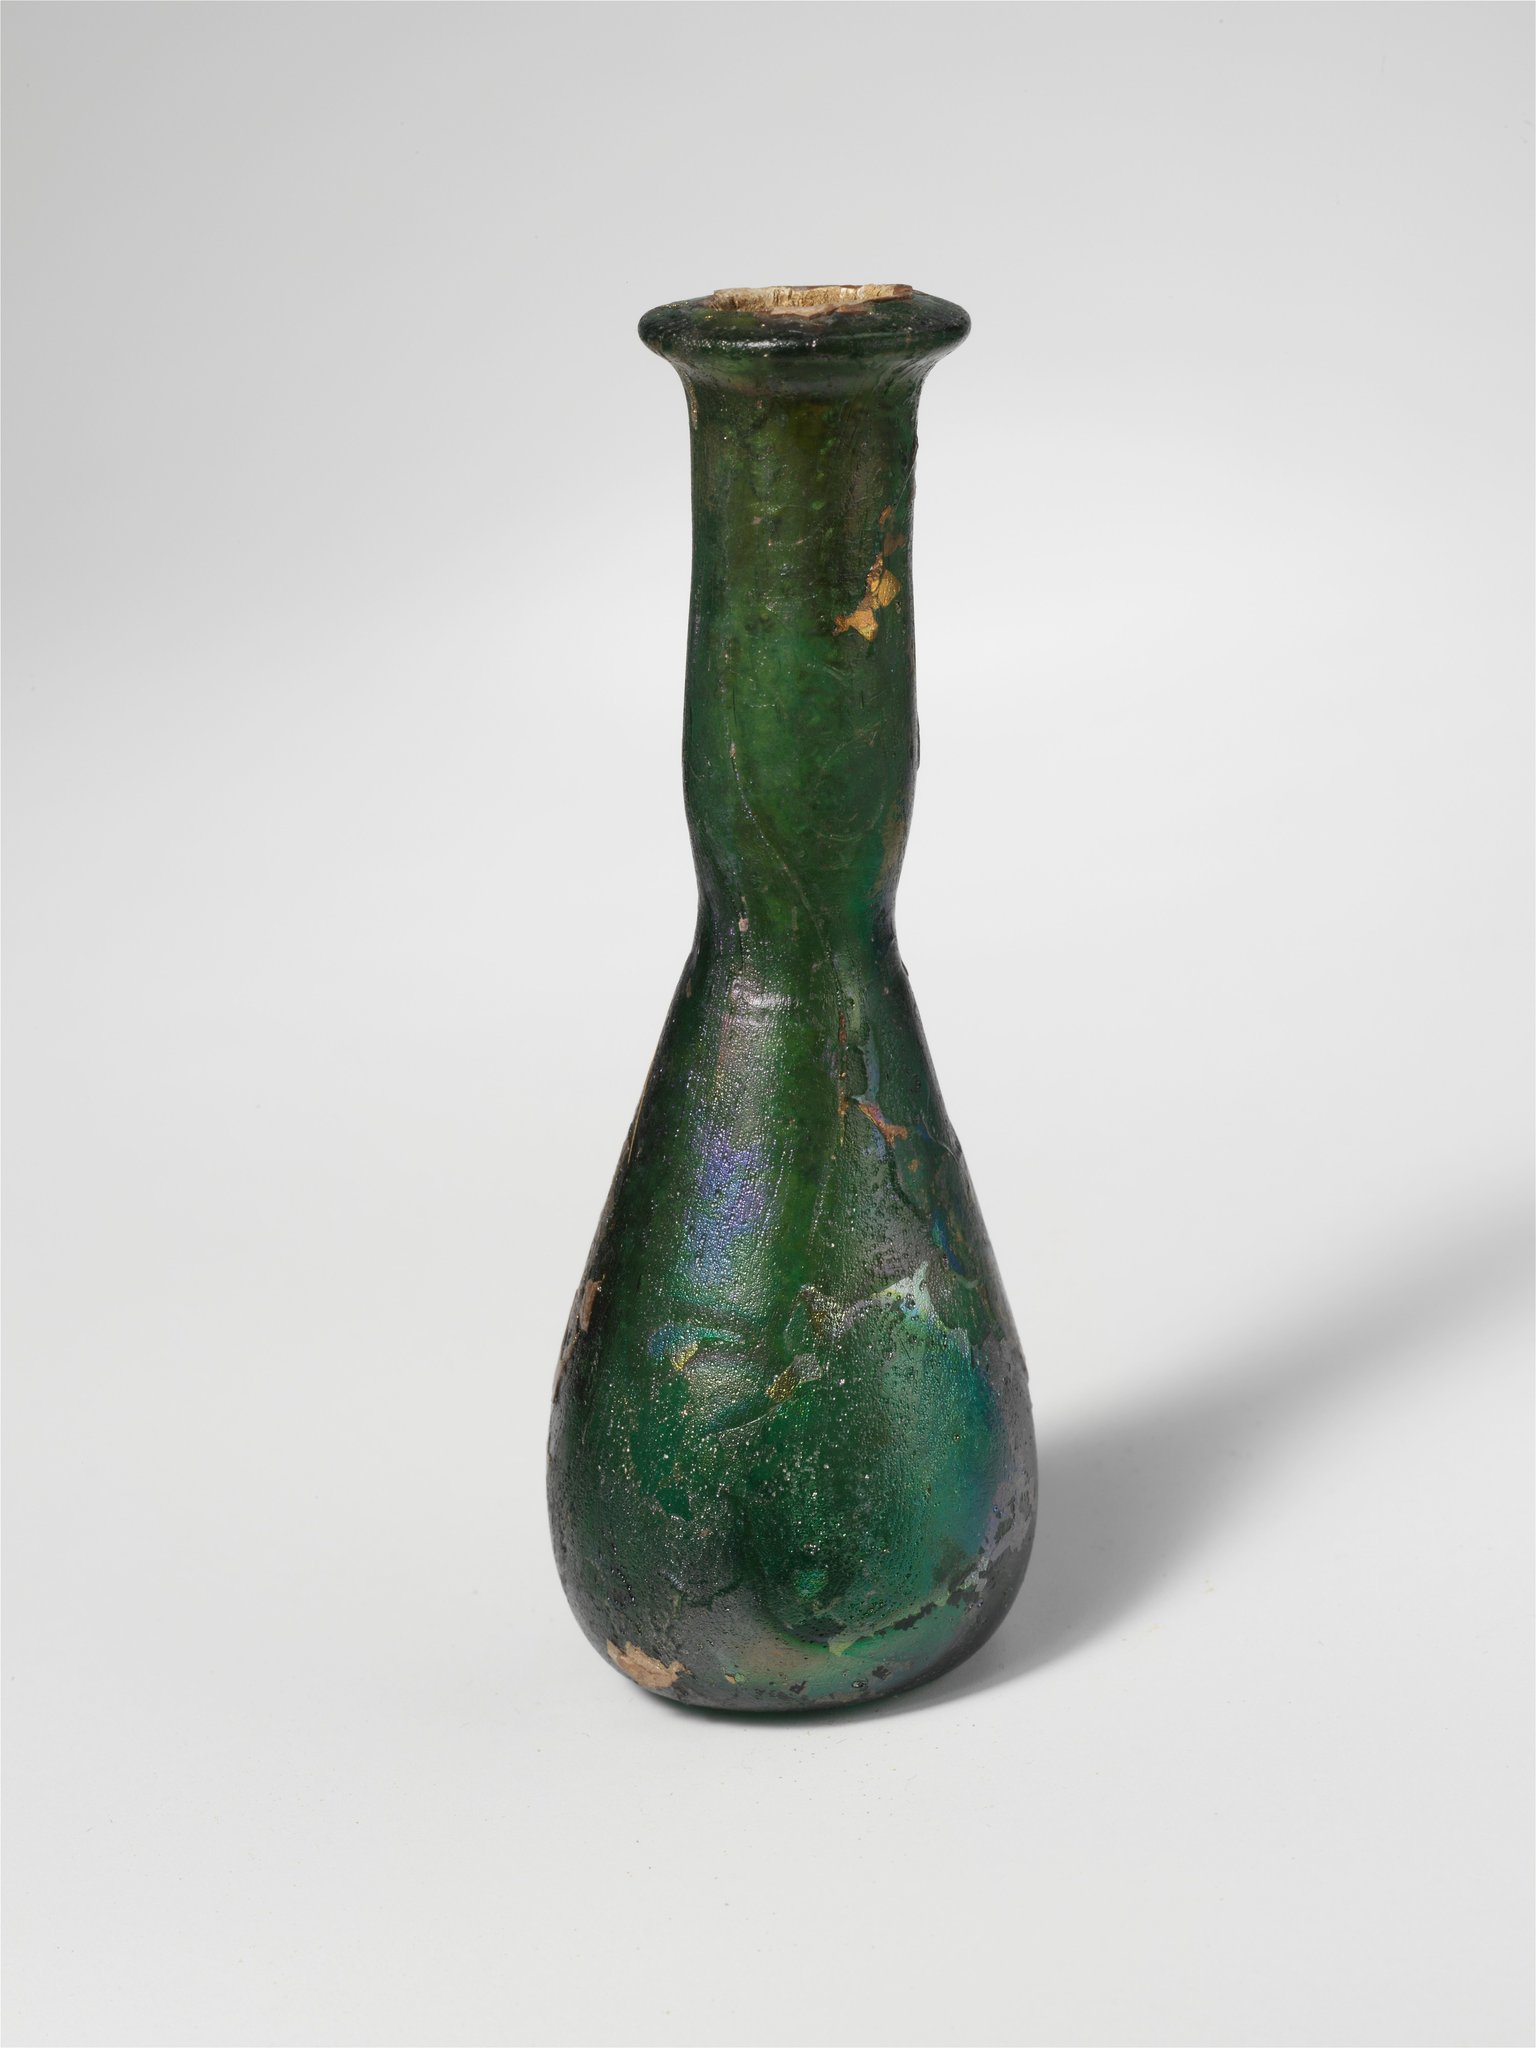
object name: perfume bottle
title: Glass perfume bottle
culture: roman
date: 1-200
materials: glass